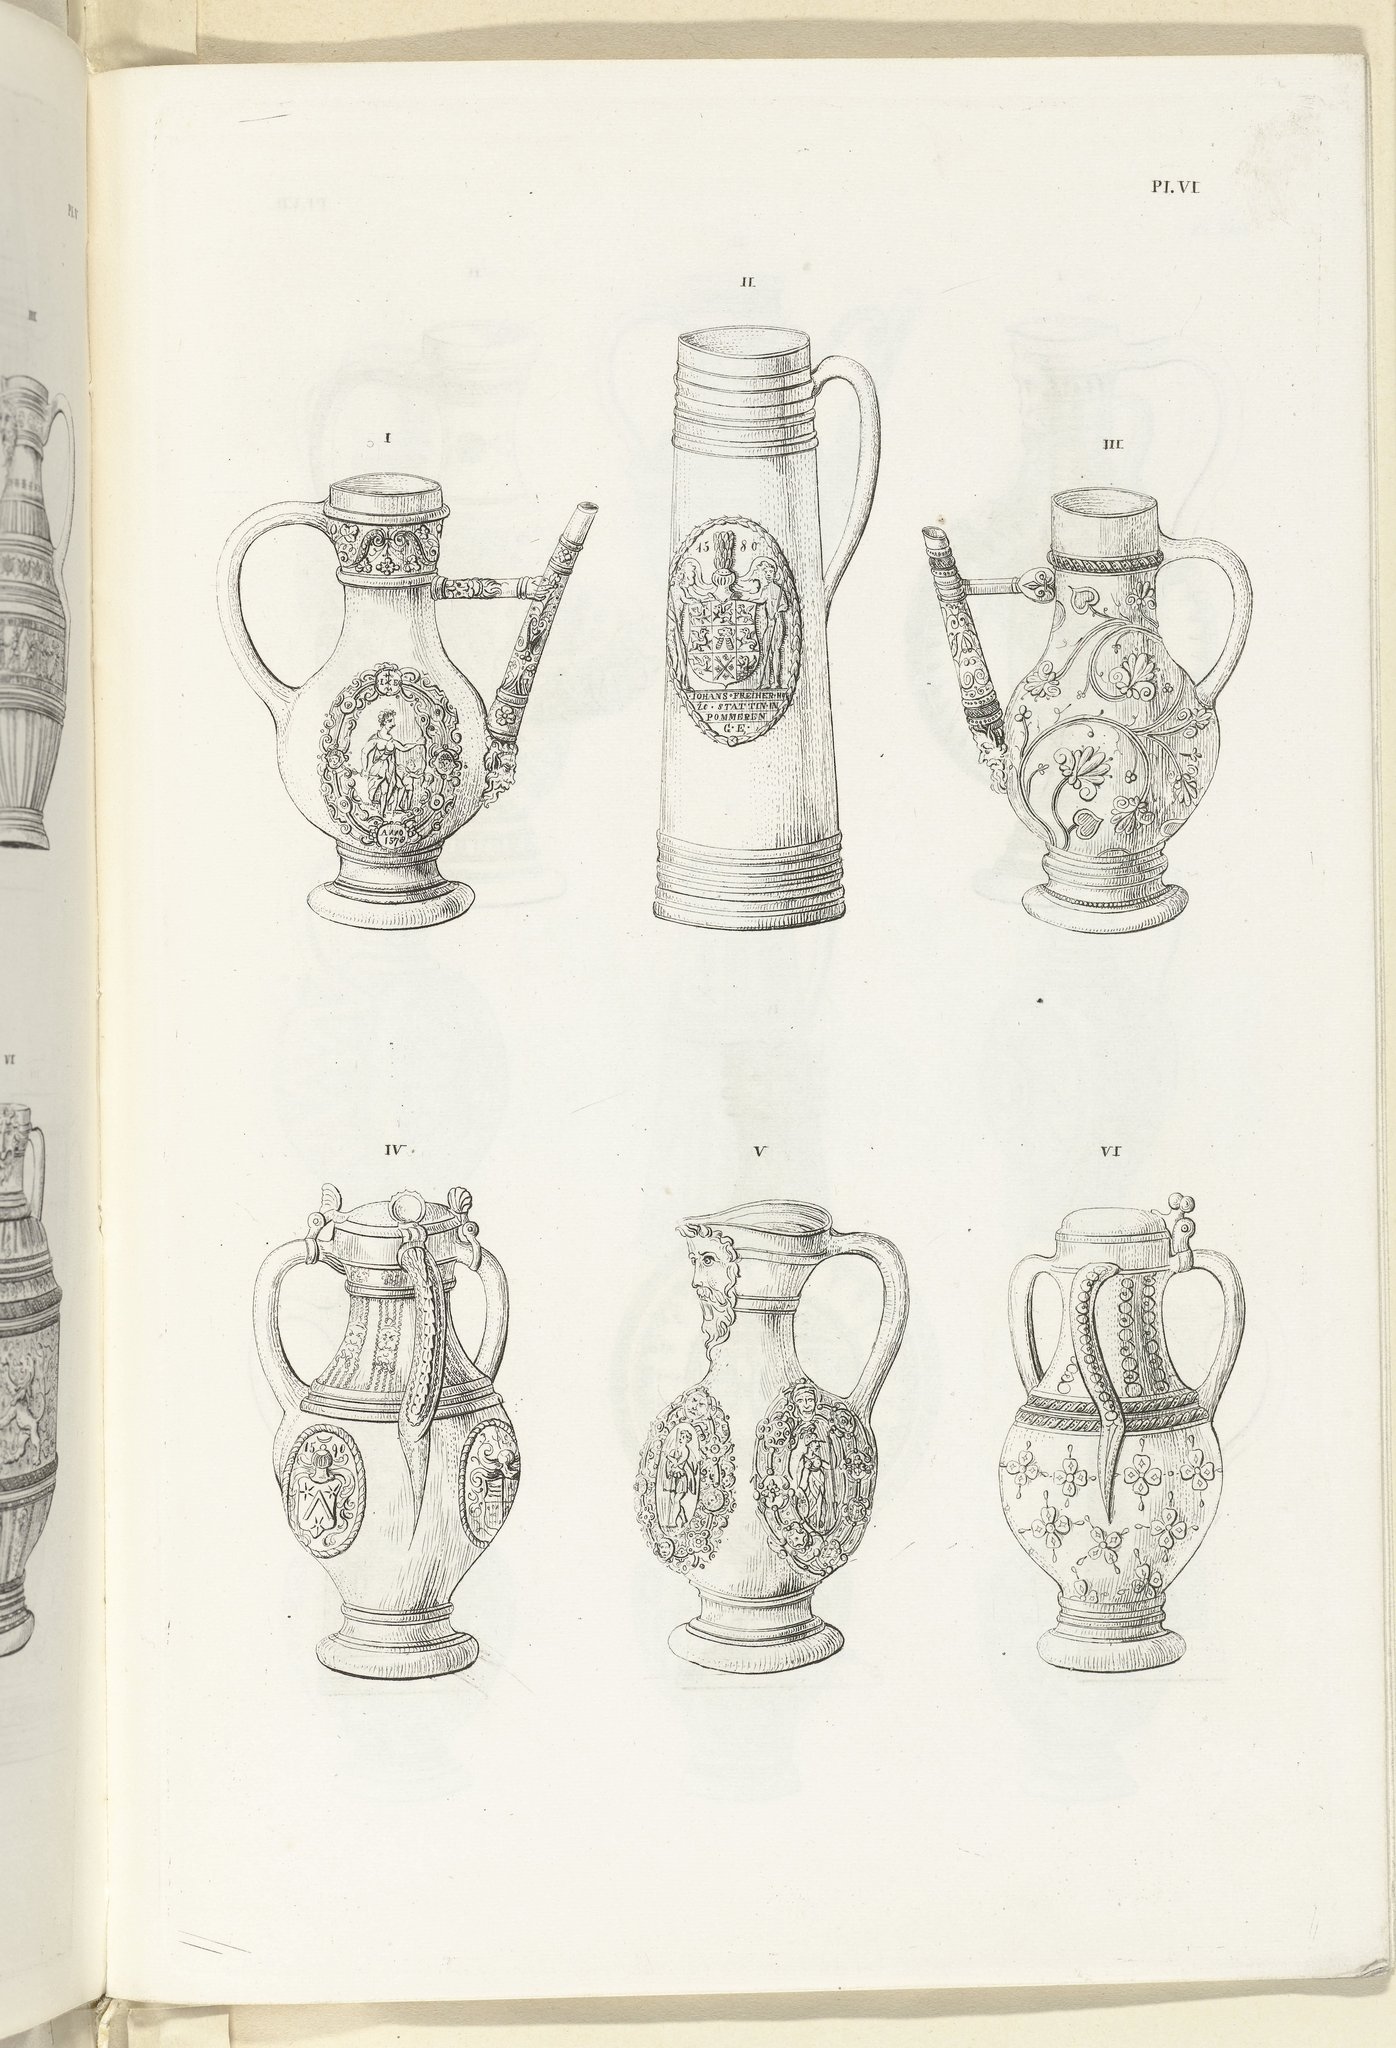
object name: print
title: Kannen van steengoed, plaat VI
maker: charles onghena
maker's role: print maker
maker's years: 1806-1886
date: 1827-1829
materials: paper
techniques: etching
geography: belgium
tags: container of ceramics: jar, jug, pot, vase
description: Onderdeel van illustraties in: Objects Rares recueillis et publiés par Joan. D'Huyvetter, P.F. Goesin-Verhaeghe, Gent 1829, plaat VI. Deze Franstalige editie bevat dezeflde platen als de Nederlandse maar is kleiner van formaat, dubbelzijdig bedrukt en zonder de inleiding. Ingebonden achterin de Nederlandstalige uitgave van hetzelfde werk: Zeldzaamheden verzameld en uitgegeven door Joan. D'Huyvetter. In het exemplaar in de collectie van de Rijksmuseum Research Library (15 D 38).